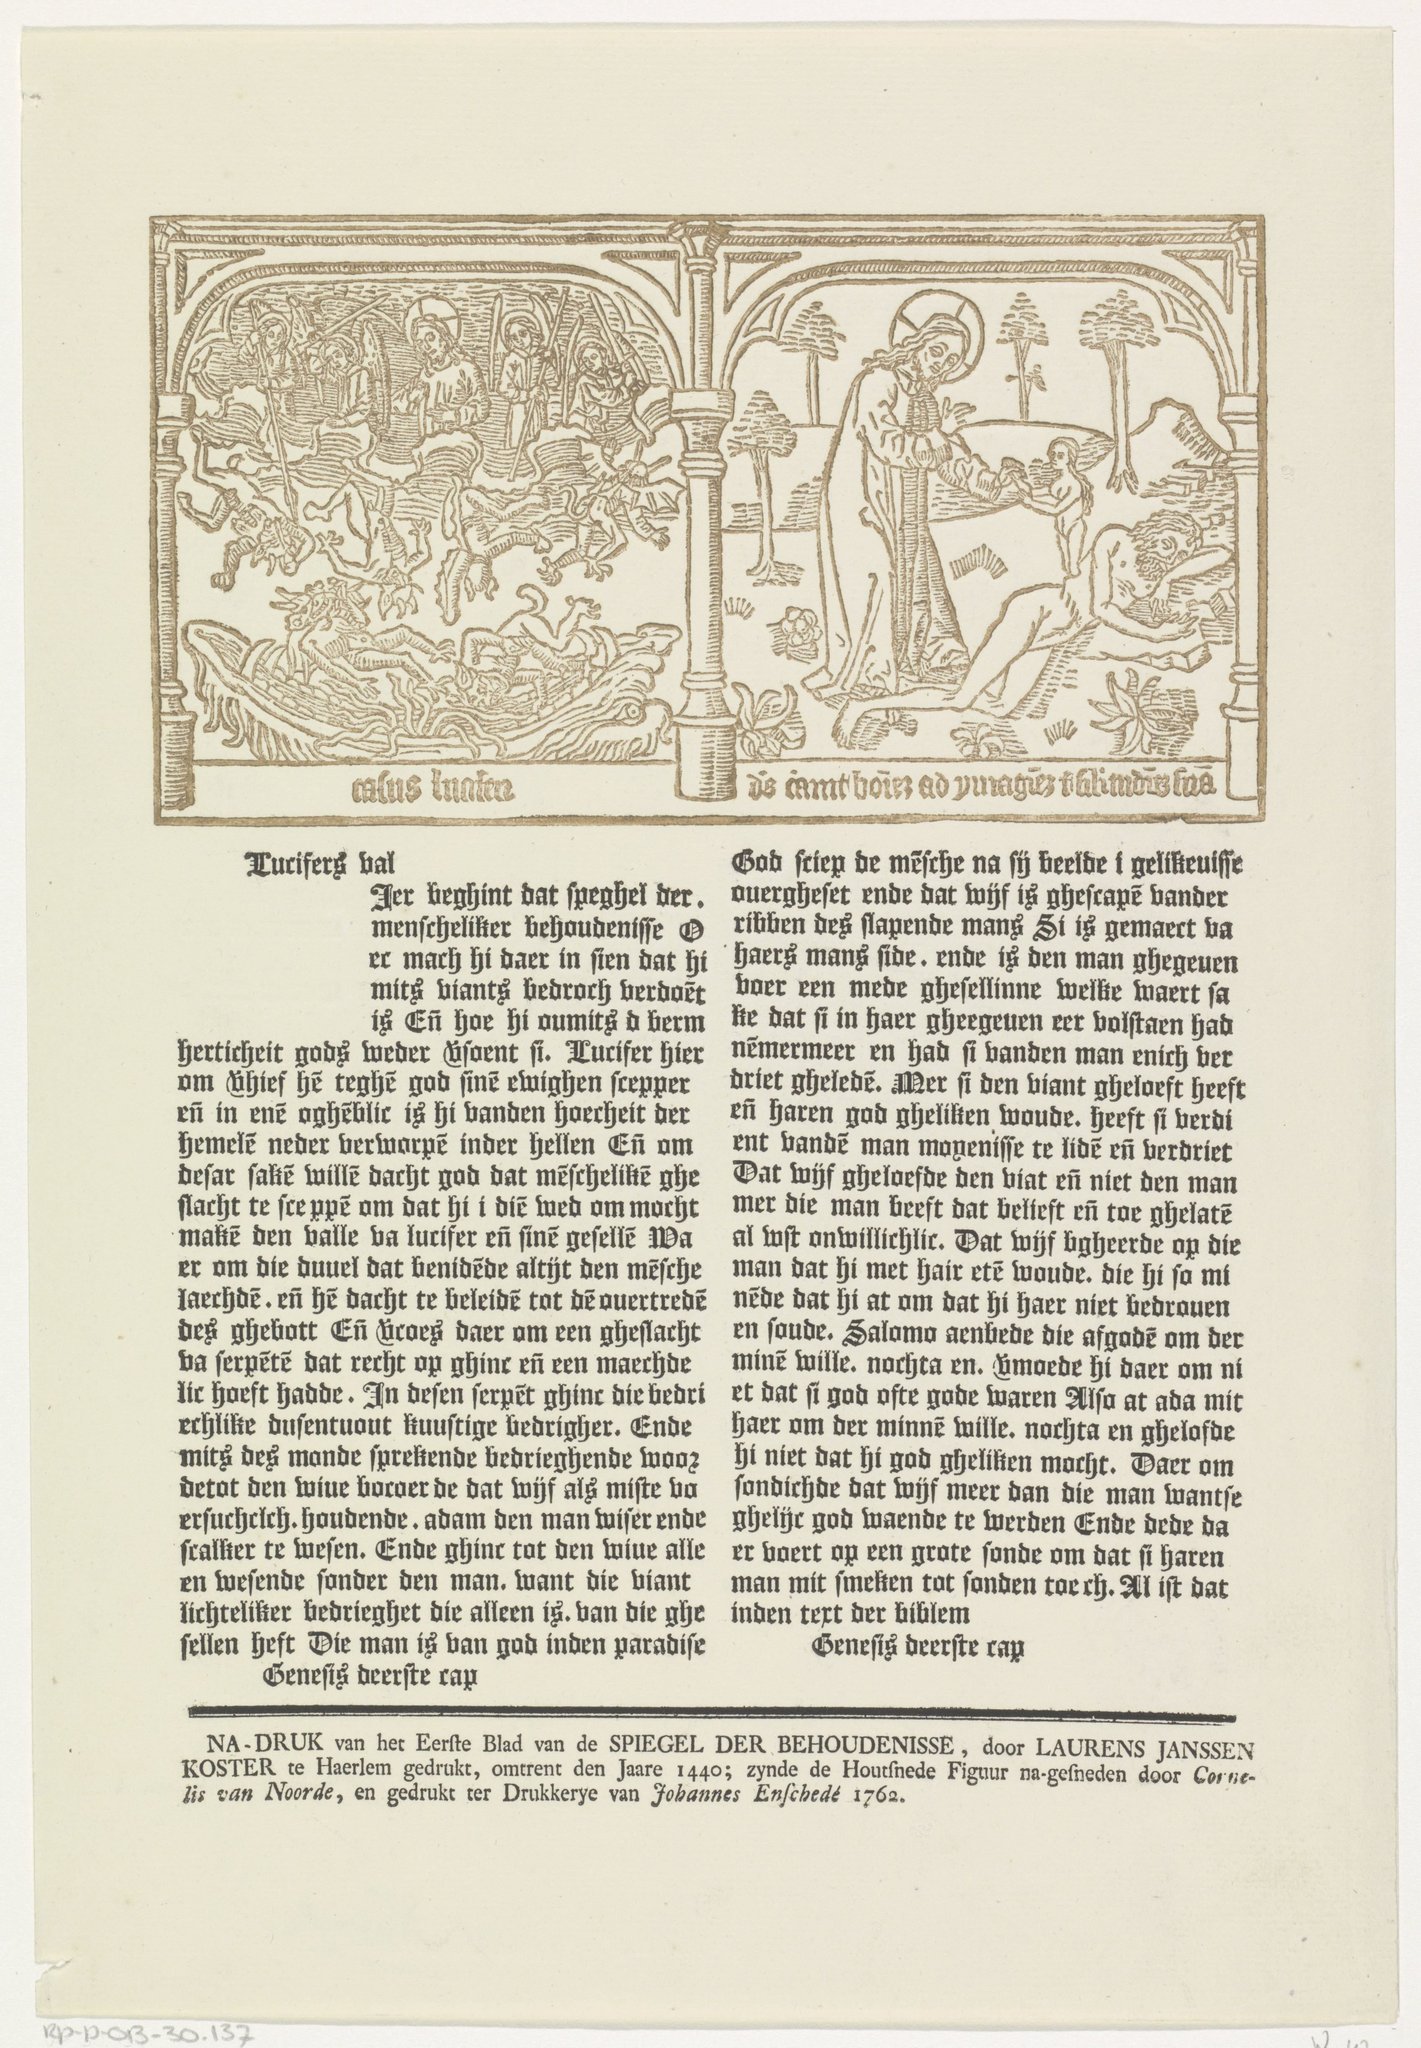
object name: print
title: Val van Lucifer (Satan) en de schepping van Eva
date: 1762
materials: paper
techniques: letterpress printing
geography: haarlem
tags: the fall of satan, fall of lucifer, creation of eve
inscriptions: collector's mark: Lugt 240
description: Links de val van Lucifer (Satan) en rechts de schepping van Eva uit een rib van Adam. In een kader twee regels Latijnse tekst. Eronder twee kolommen met Nederlandse tekst.